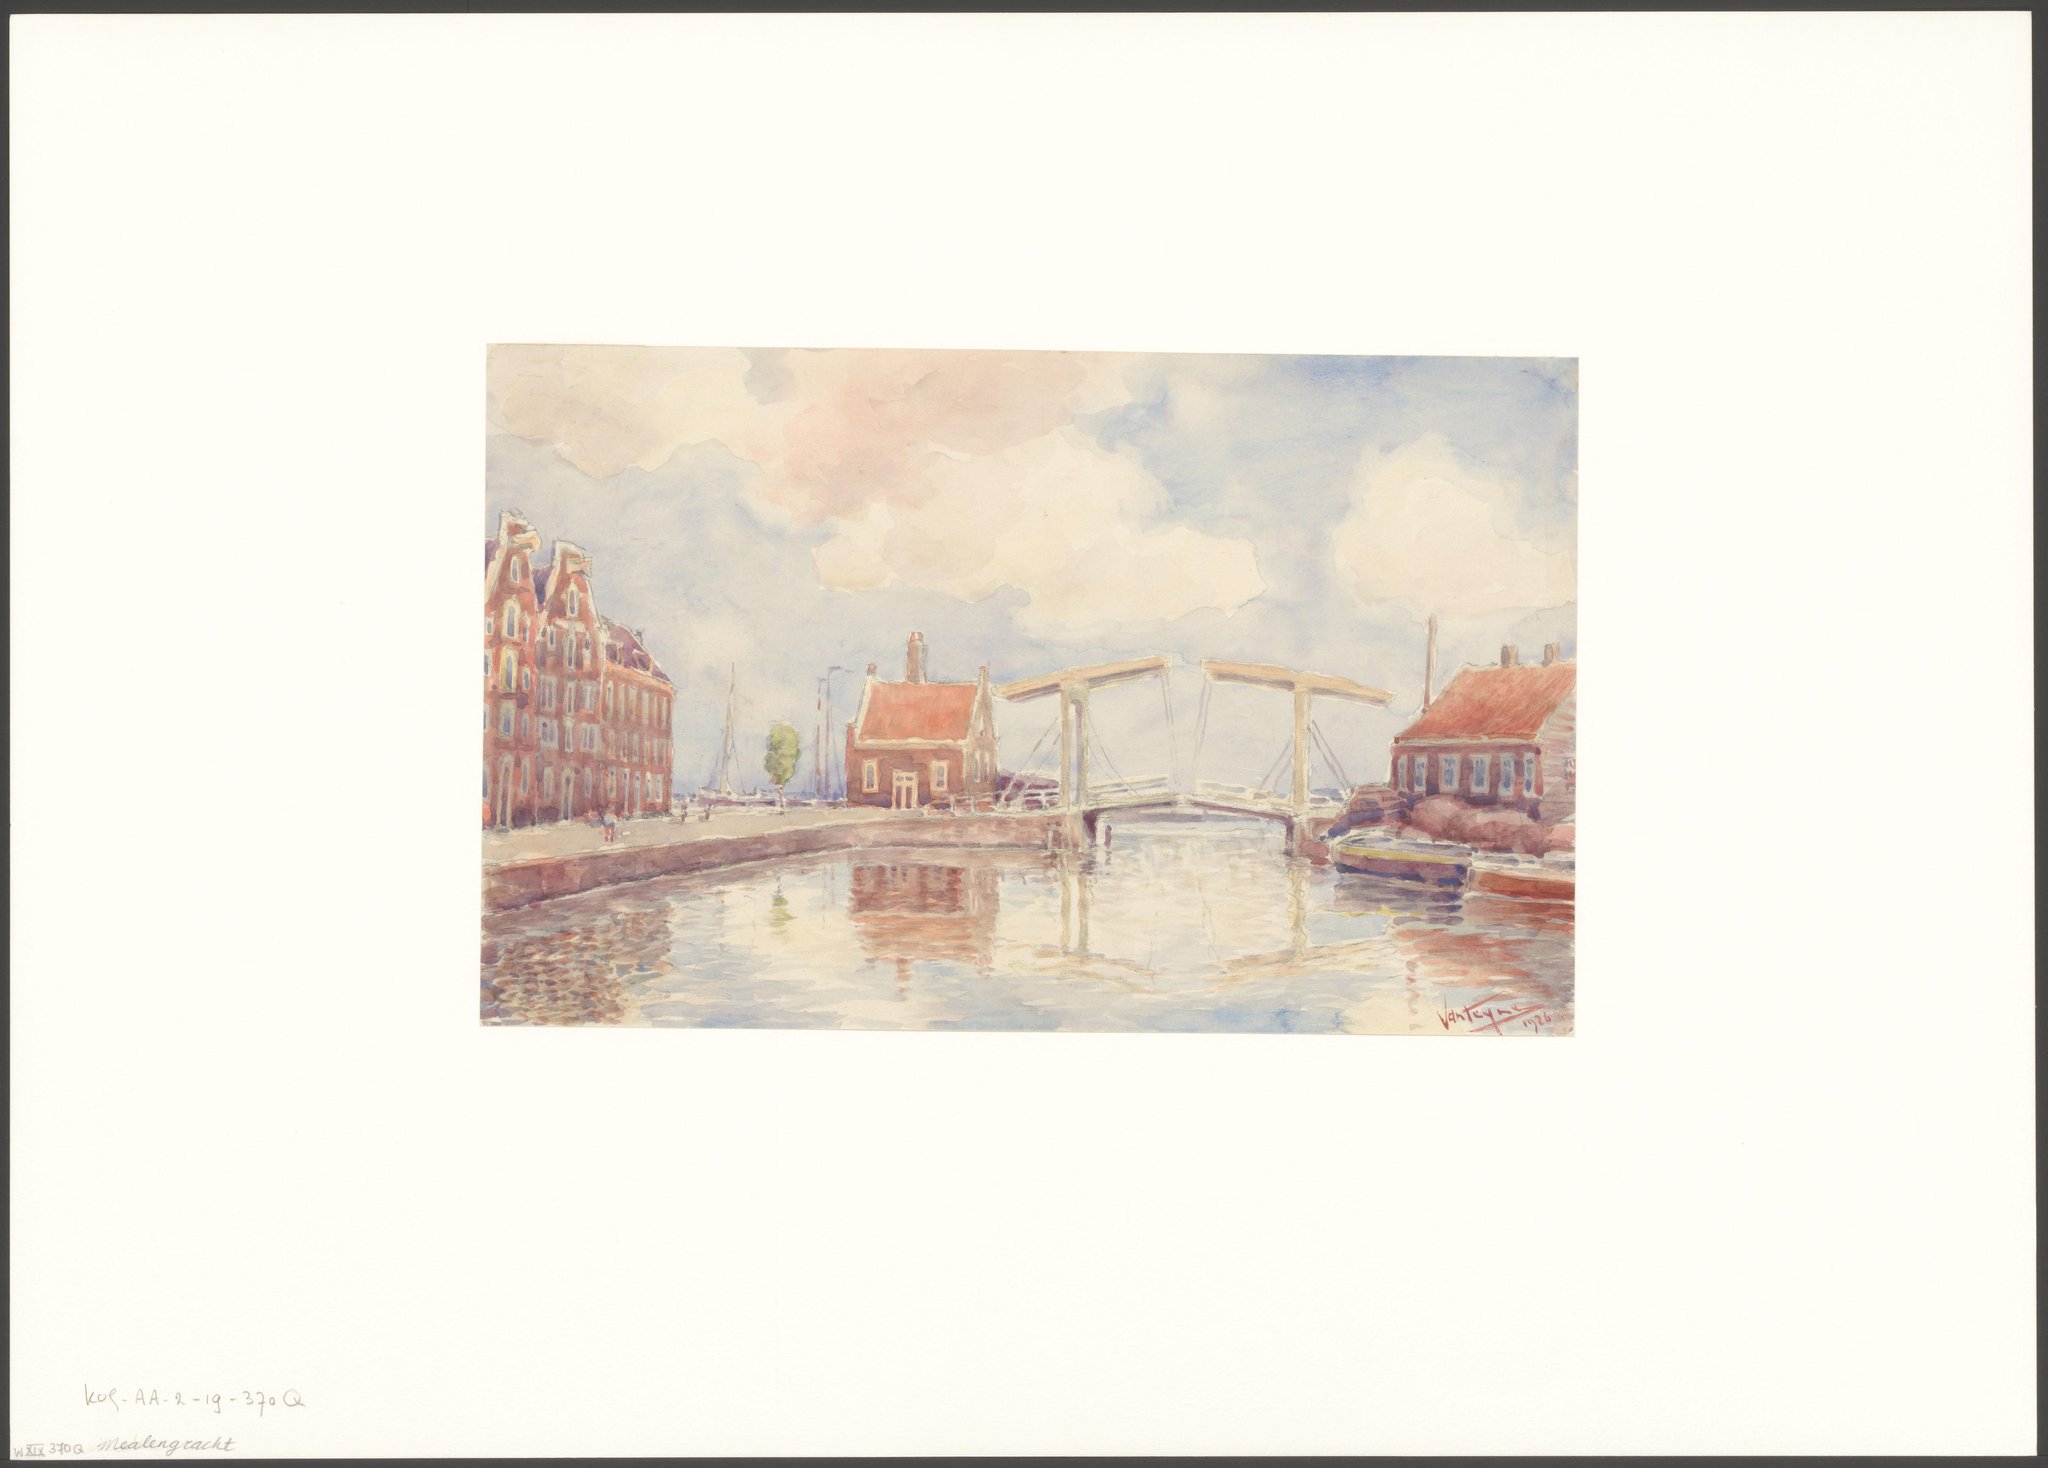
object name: drawing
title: Gezicht op de Realengracht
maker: anthonie van teijn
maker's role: draughtsman, painter, print maker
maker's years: 1863-1943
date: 1926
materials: chalk, paper, watercolor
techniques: brush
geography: amsterdam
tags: city-view in general; 'veduta', canal, bridge in city across river, canal, etc.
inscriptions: inscription: ‘Realengracht’, signature and date: ‘VanTeyne / 1926’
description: Tekening binnen de Atlas Van Eck ingedeeld op wijknummer 19.